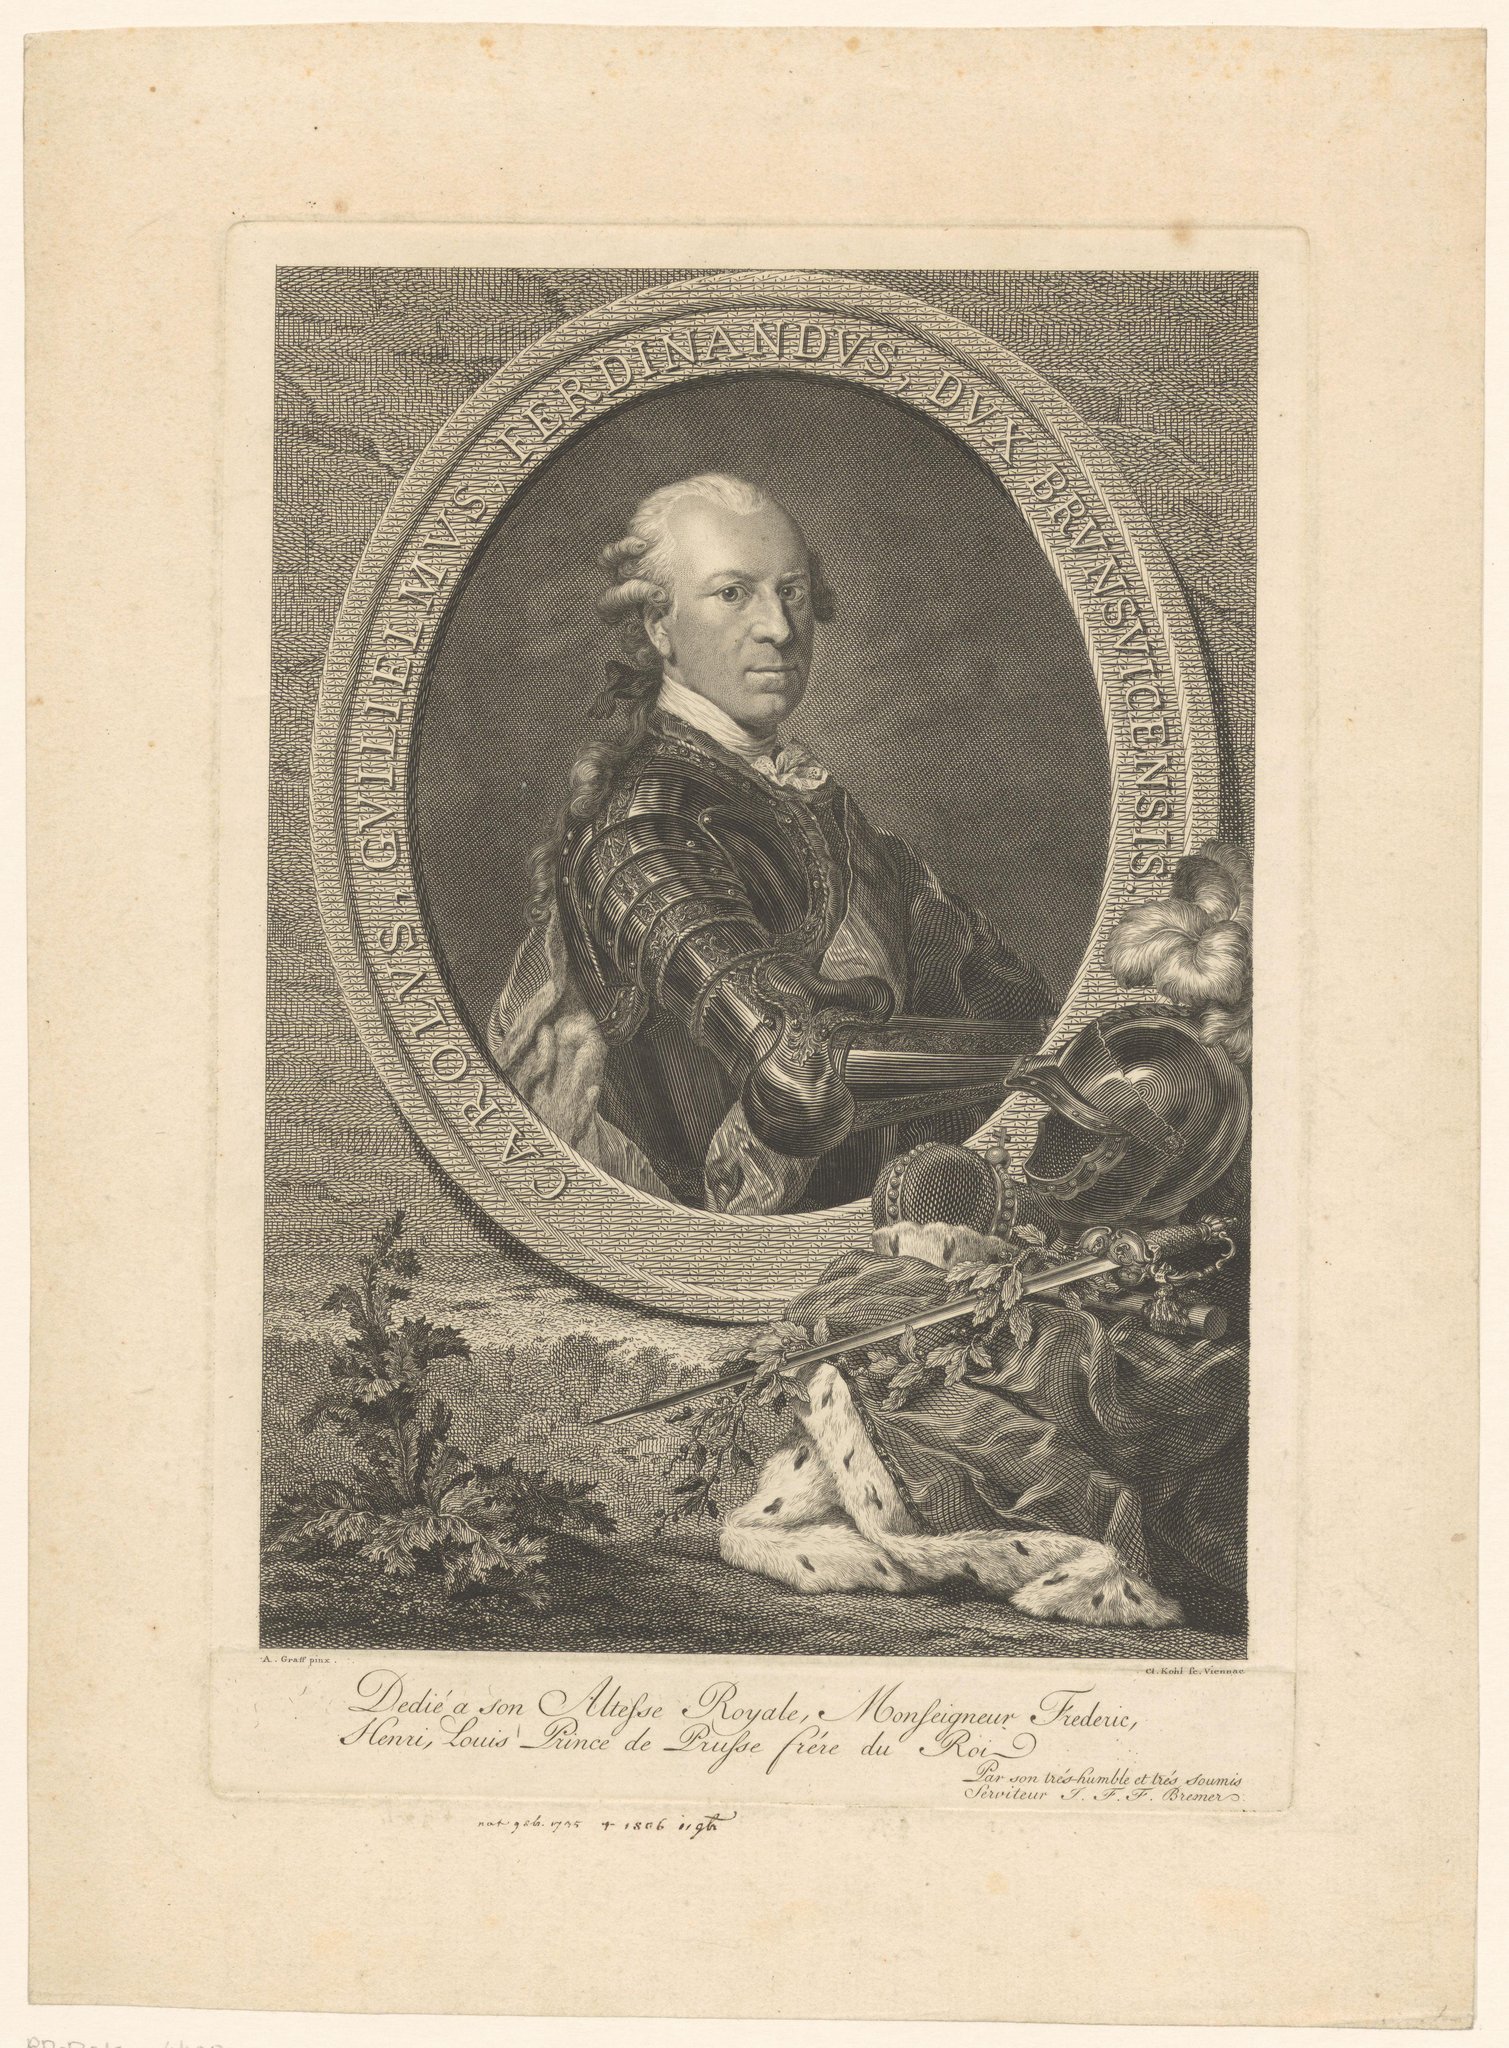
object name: print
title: Portret van Karl Wilhelm Ferdinand von Braunschweig-Wolfenbüttel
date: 1787-1807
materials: paper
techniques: engraving, etching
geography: vienna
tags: karl wilhelm ferdinand von braunschweig-wolfenbüttel (hertog), commander-in-chief, general, marshal, historical persons, ruler, sovereign, military clothing and other equipment (uniforms, cap, armour, helmet, etc.), insignia and symbols of sovereignty (crown, diadem, sceptre, orb, seal, standard, cloak, pectoral)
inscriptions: collector's mark: Lugt 9, collector's mark: Lugt 2228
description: Tekst in het Latijn in de omlijsting en tekst in het Frans in de ondermarge.